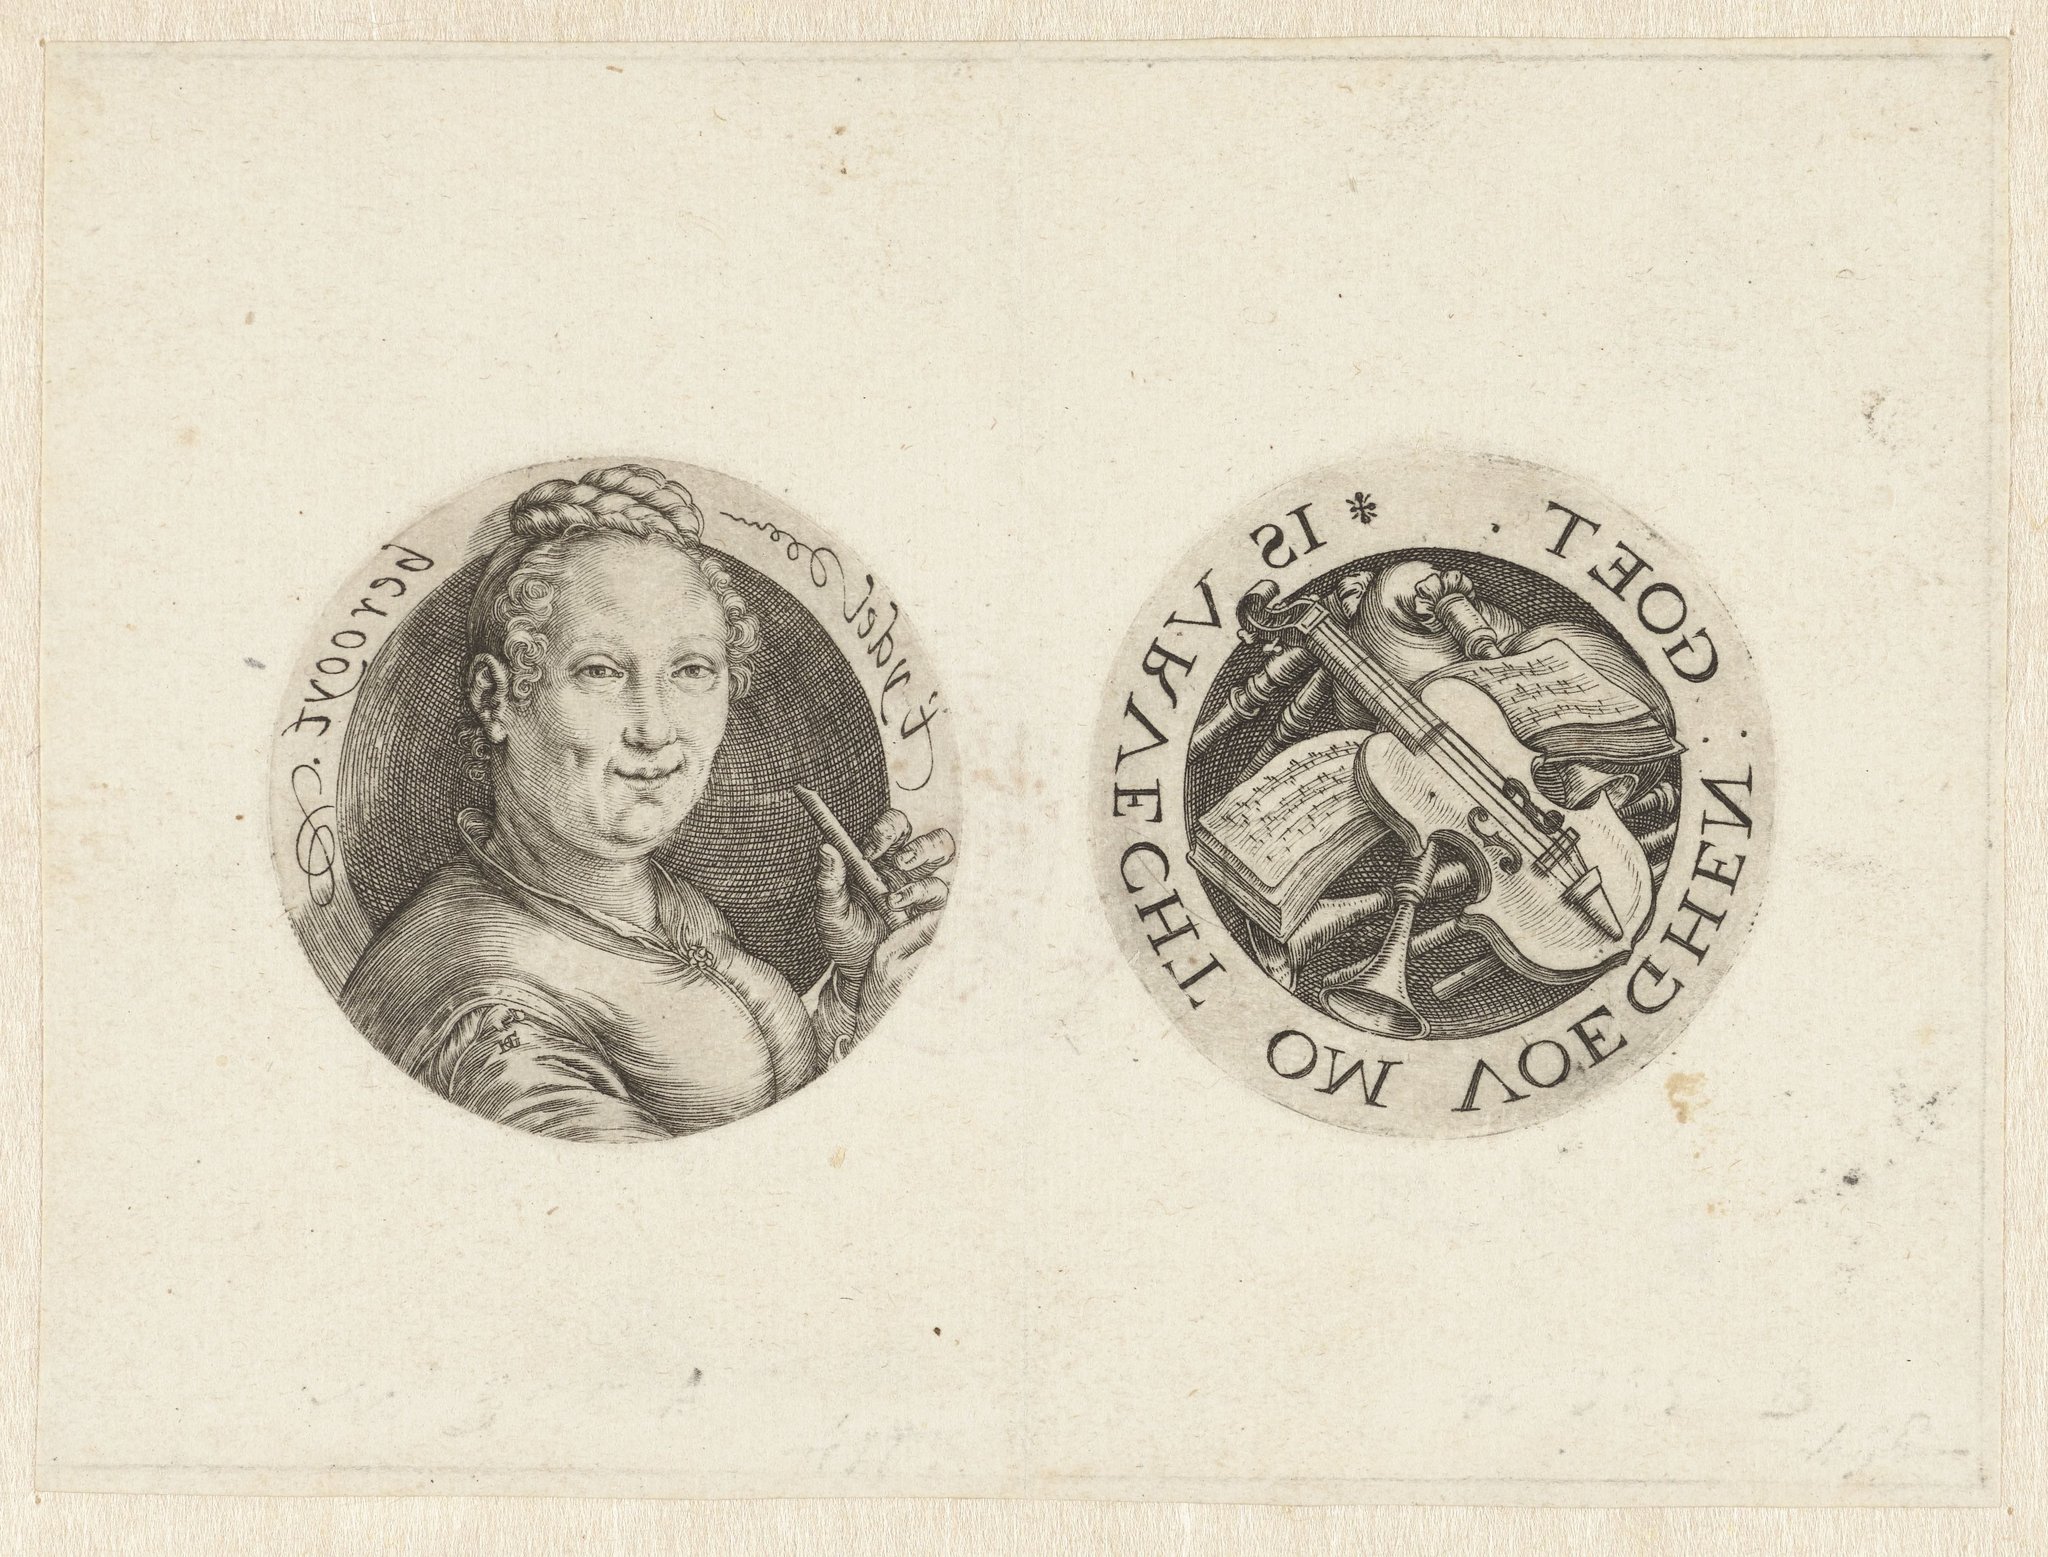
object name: print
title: Fantasy Portrait of a Woman with a Flute, and Musical Instruments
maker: hendrick goltzius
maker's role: draughtsman, painter, print maker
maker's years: 1558-1617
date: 1598-1602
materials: paper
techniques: engraving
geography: haarlem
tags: musical instruments; group of musical instruments, anonymous historical person portrayed alone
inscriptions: collector's mark: Lugt 240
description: This sheet features impressions of both sides of a single medallion. Its pendant presents a fantasy portrait of a bagpiper, of which only an impression of the portrait side is known. They complemented each other and together also had an amusing function: the verses rhyme and together the images are full of erotic allusions. Flutes and bagpipes symbolized male genitalia.